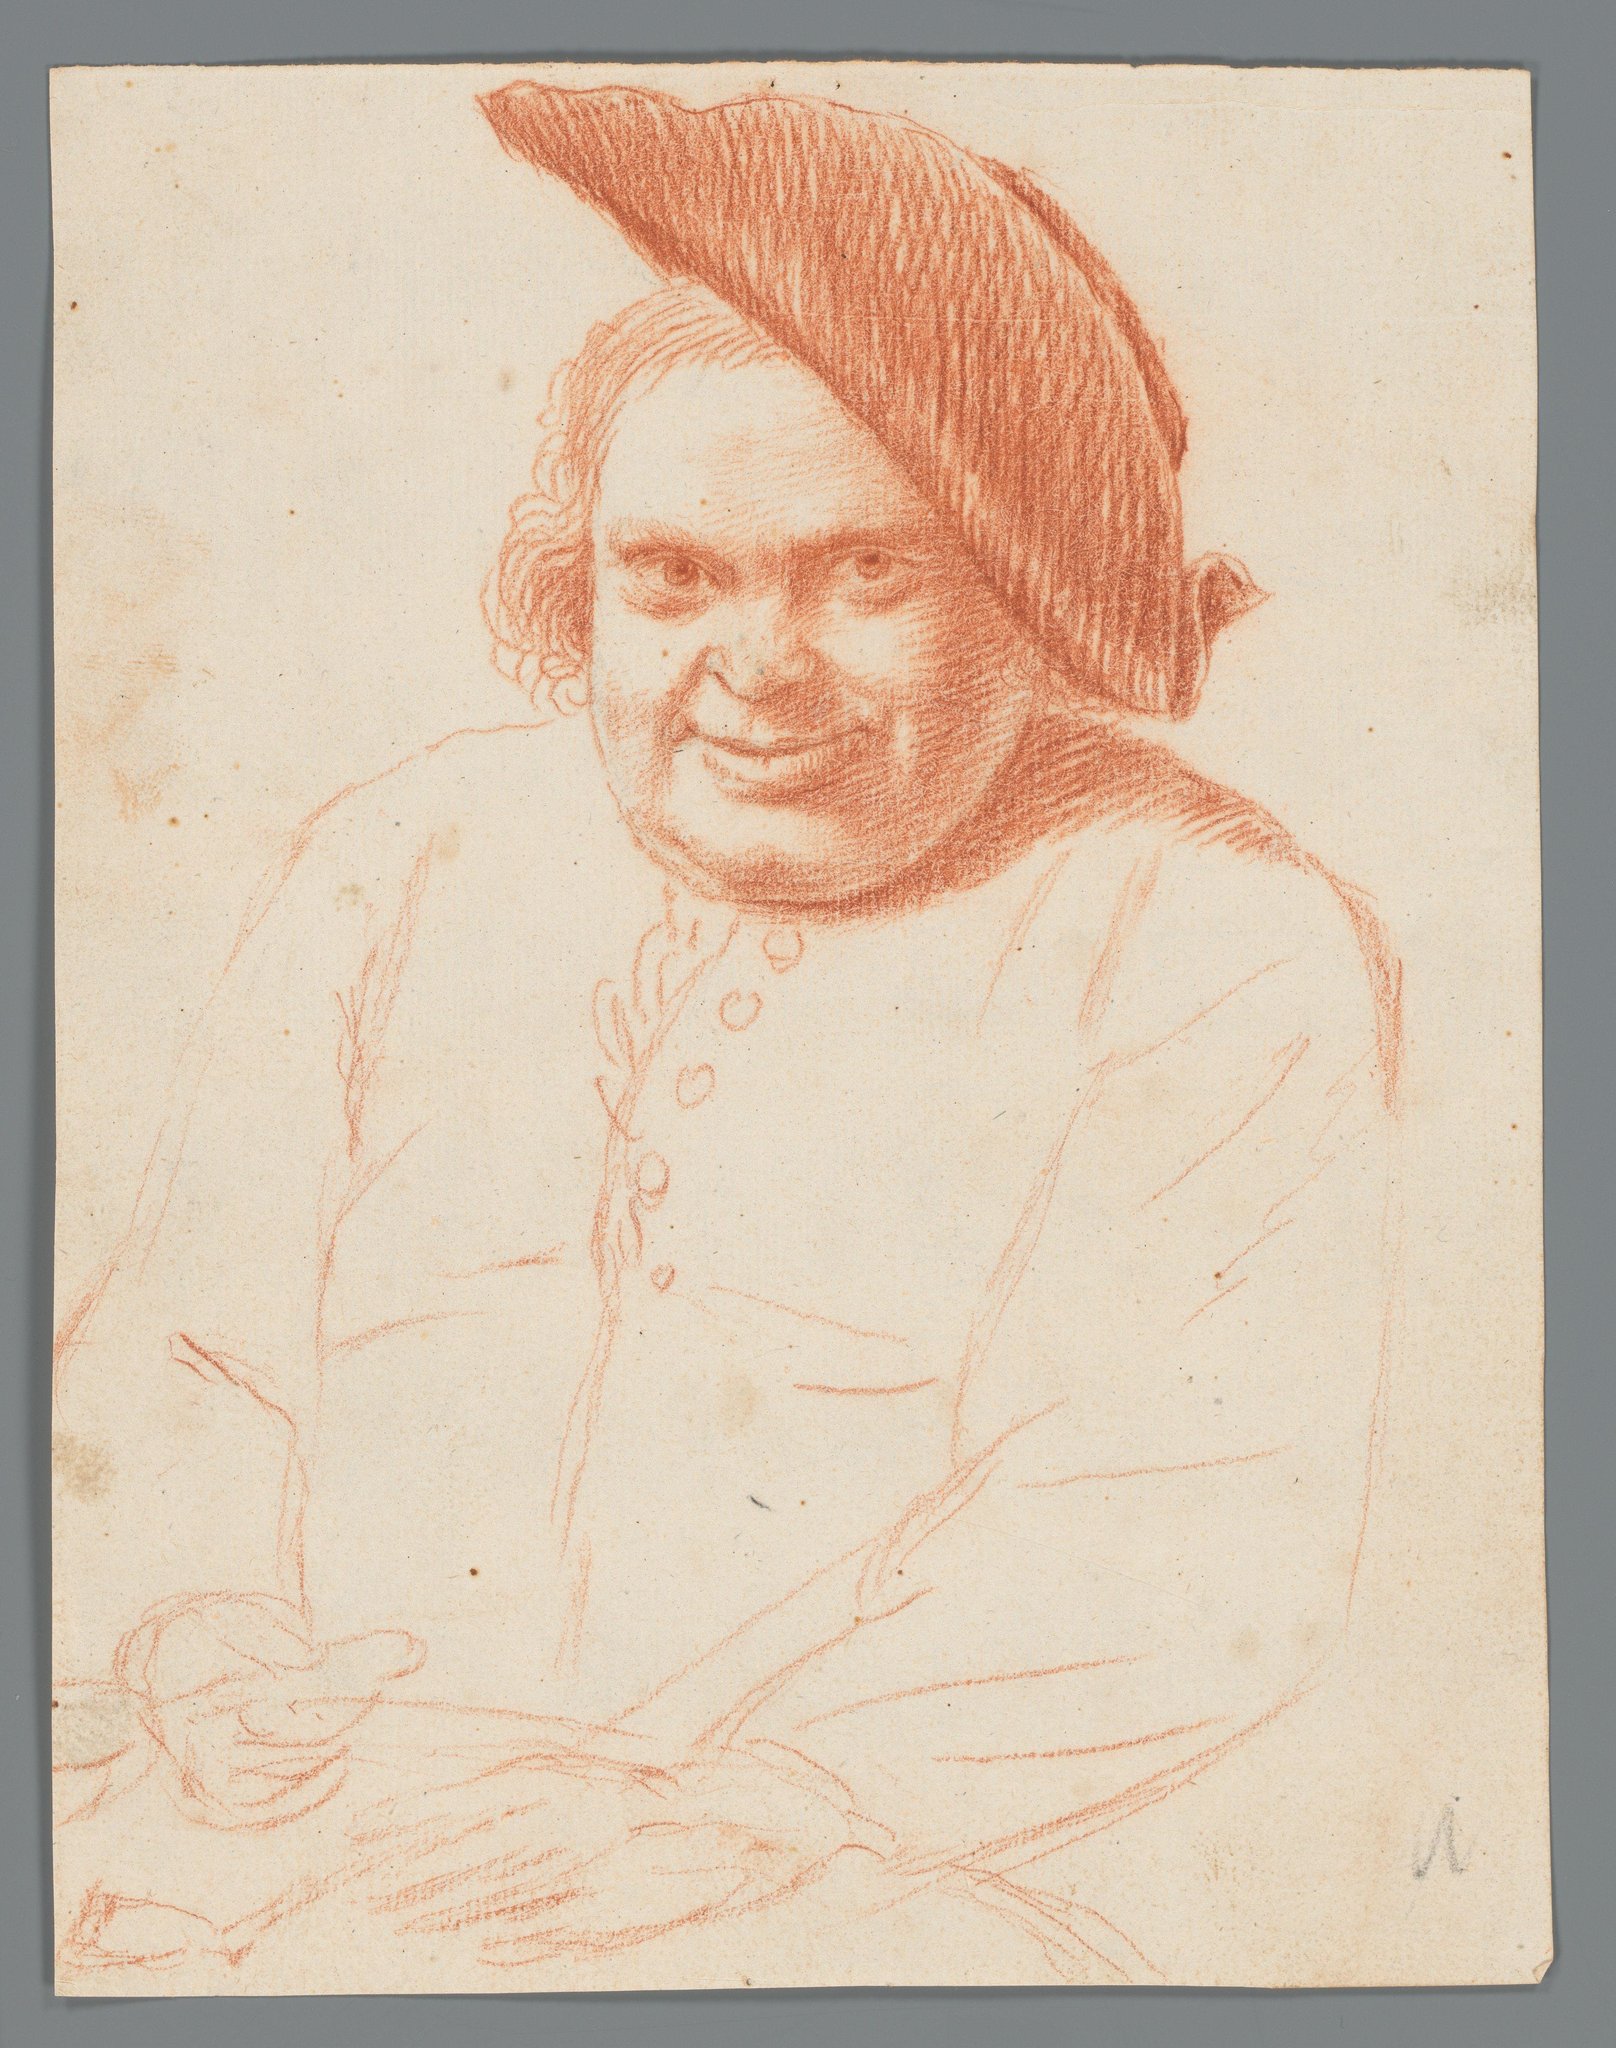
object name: drawing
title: Tronie van een man met hoed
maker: matthijs balen (1684-1766)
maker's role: draughtsman, painter, print maker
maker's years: 1684-1766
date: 1694-1766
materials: chalk, paper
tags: head-gear: hat, glass, rummer